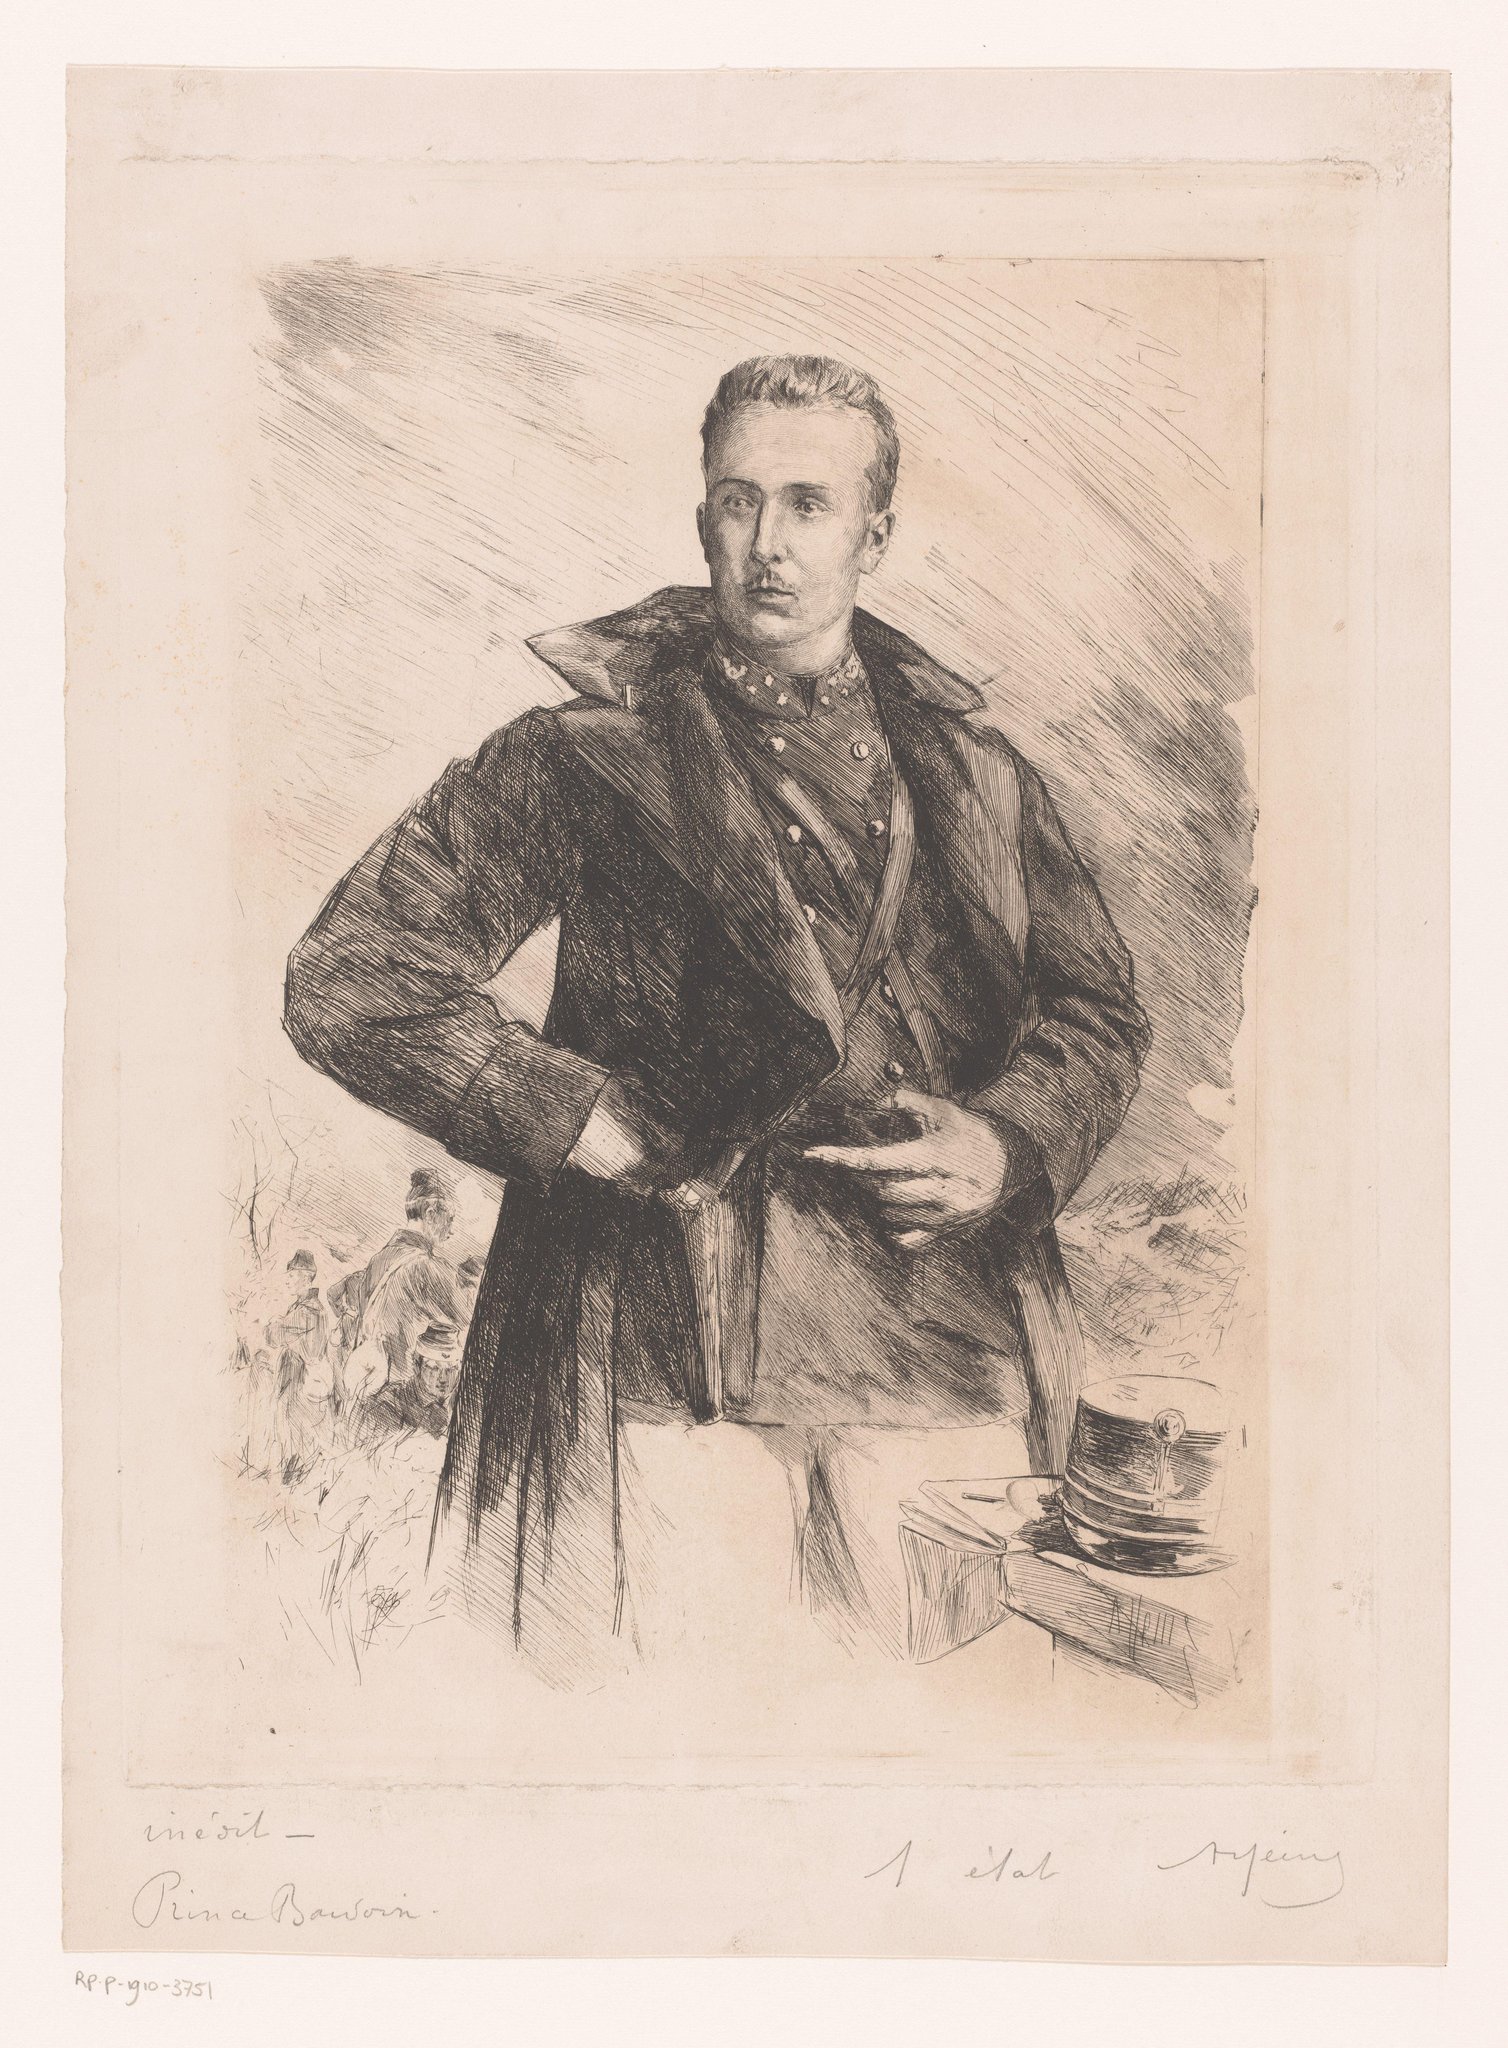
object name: print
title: Portret van prins Boudewijn van België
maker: armand heins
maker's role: print maker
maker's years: 1856-1938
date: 1866-1910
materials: paper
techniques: etching, intaglio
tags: historical persons, youth, adolescent, (military) uniforms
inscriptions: collector's mark: Lugt 2228, inscription: ‘[Unedit] Prince Baudoin; 1 état Heins’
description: Prins Boudewijn draagt een militair uniform. Op de achtergrond andere militairen.